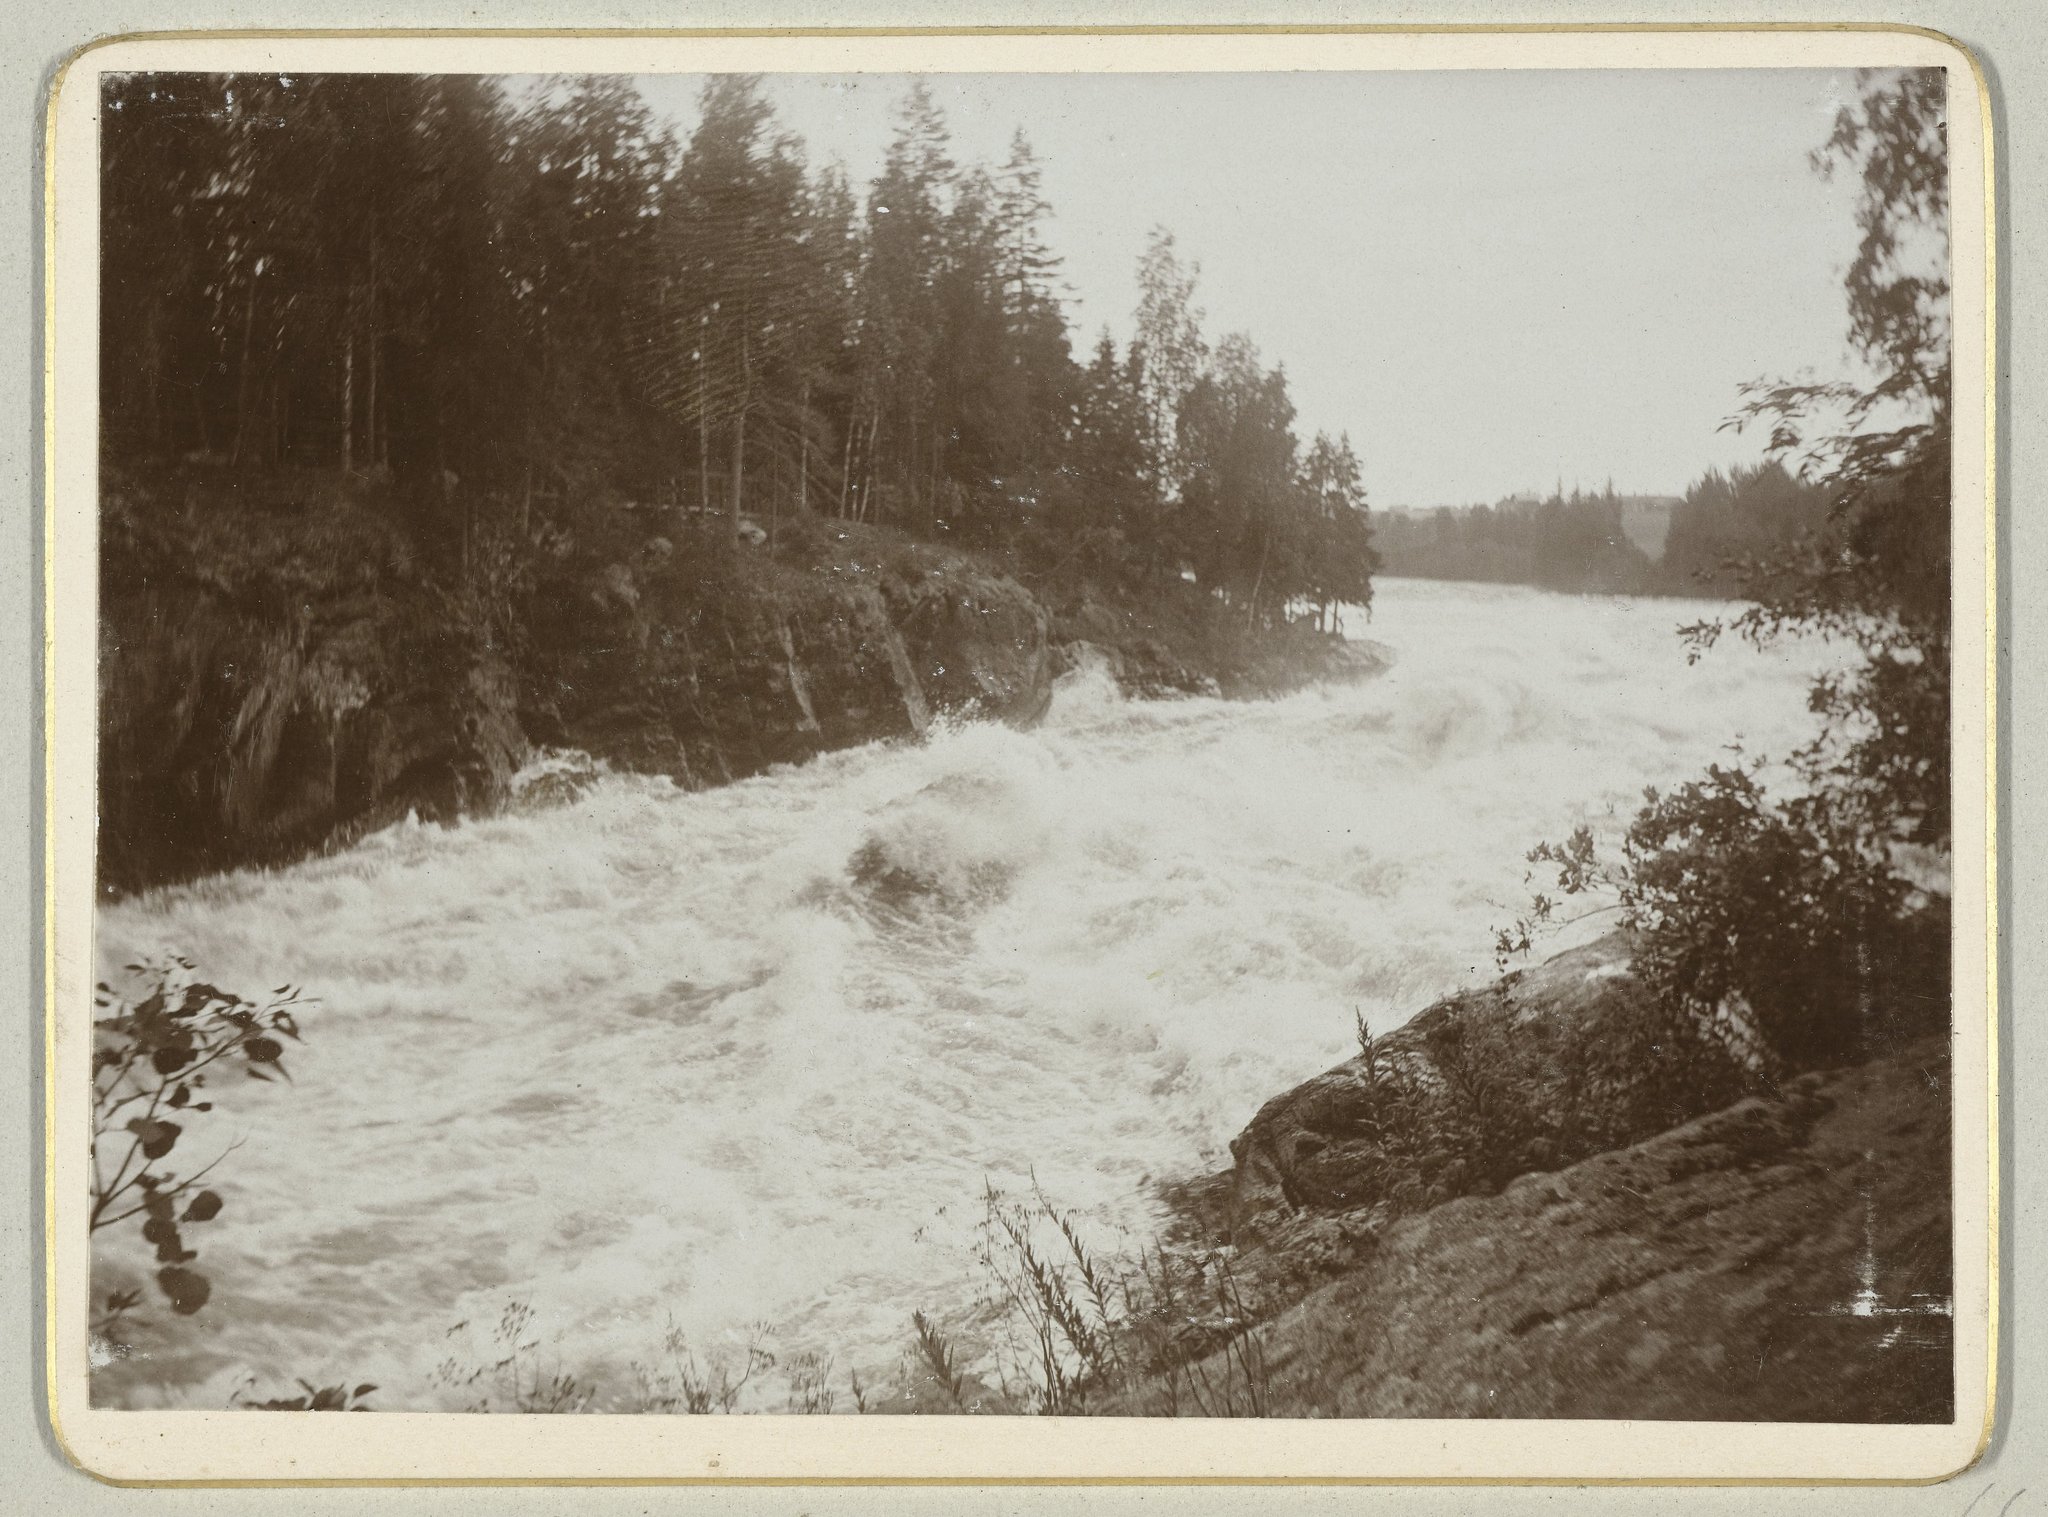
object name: photograph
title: Finland Imatra waterval.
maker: henry pauw van wieldrecht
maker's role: fotograaf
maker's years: 1863-1912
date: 1898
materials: paper, photographic support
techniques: albumen print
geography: netherlands